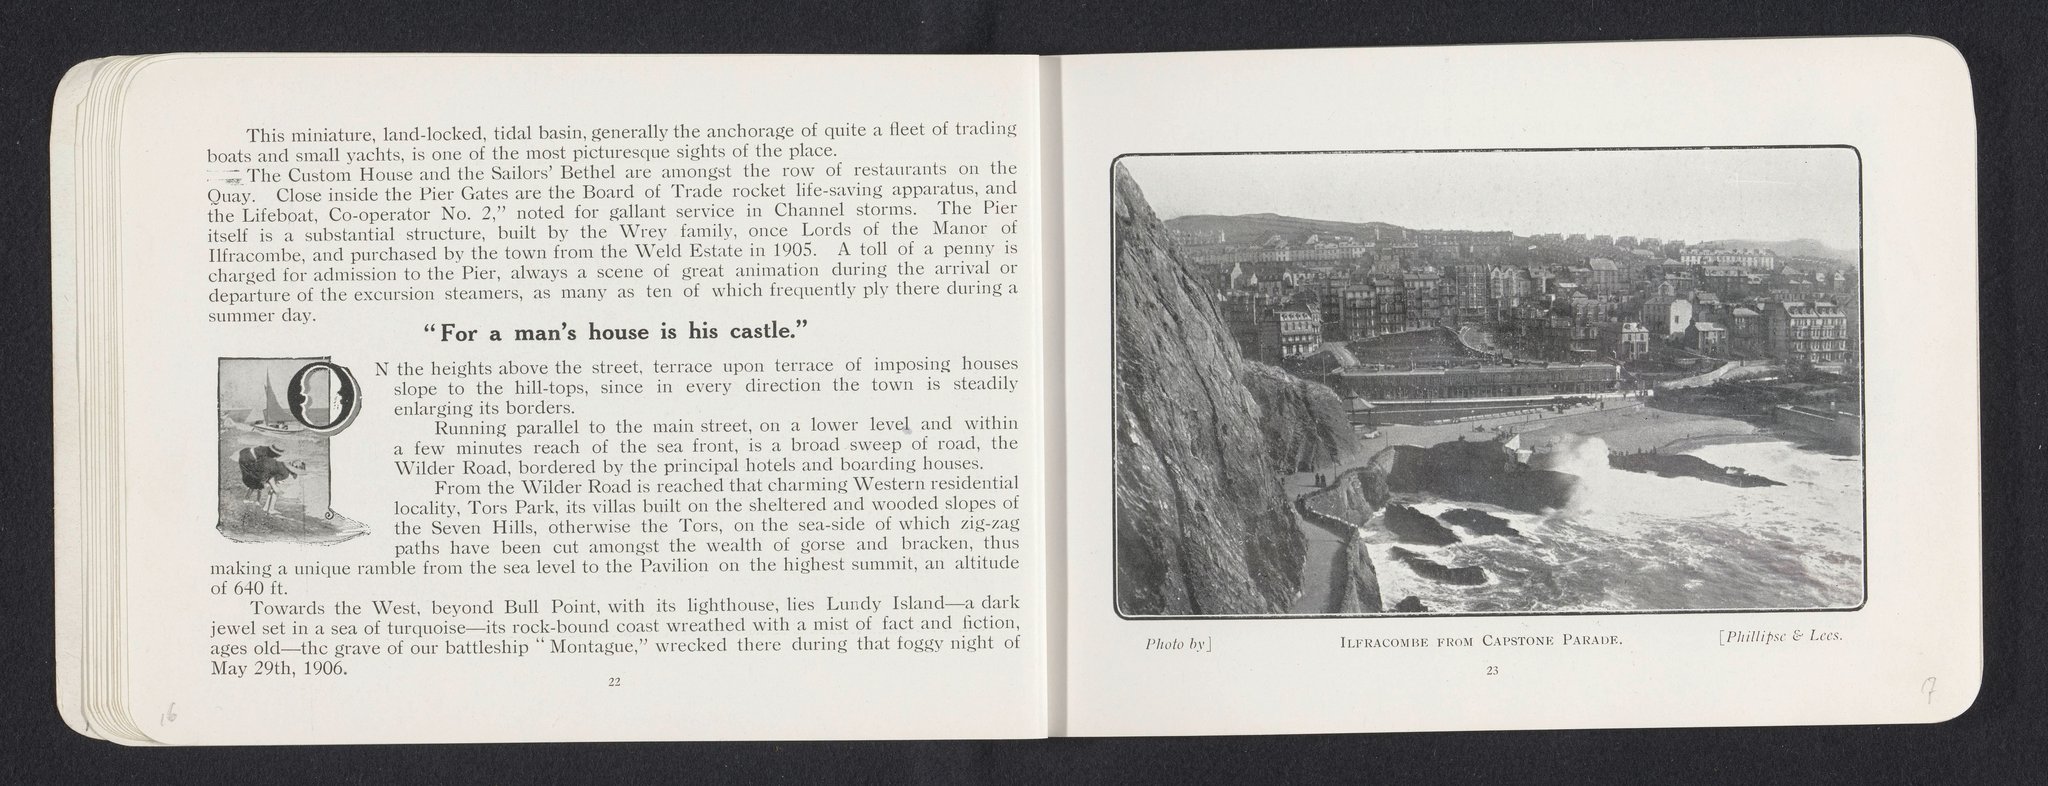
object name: photomechanical print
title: Ilfracombe from Capstone Parade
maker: Anonymous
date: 1900-1920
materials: paper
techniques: autotype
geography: ilfracombe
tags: city-view in general; 'veduta', rocky coast